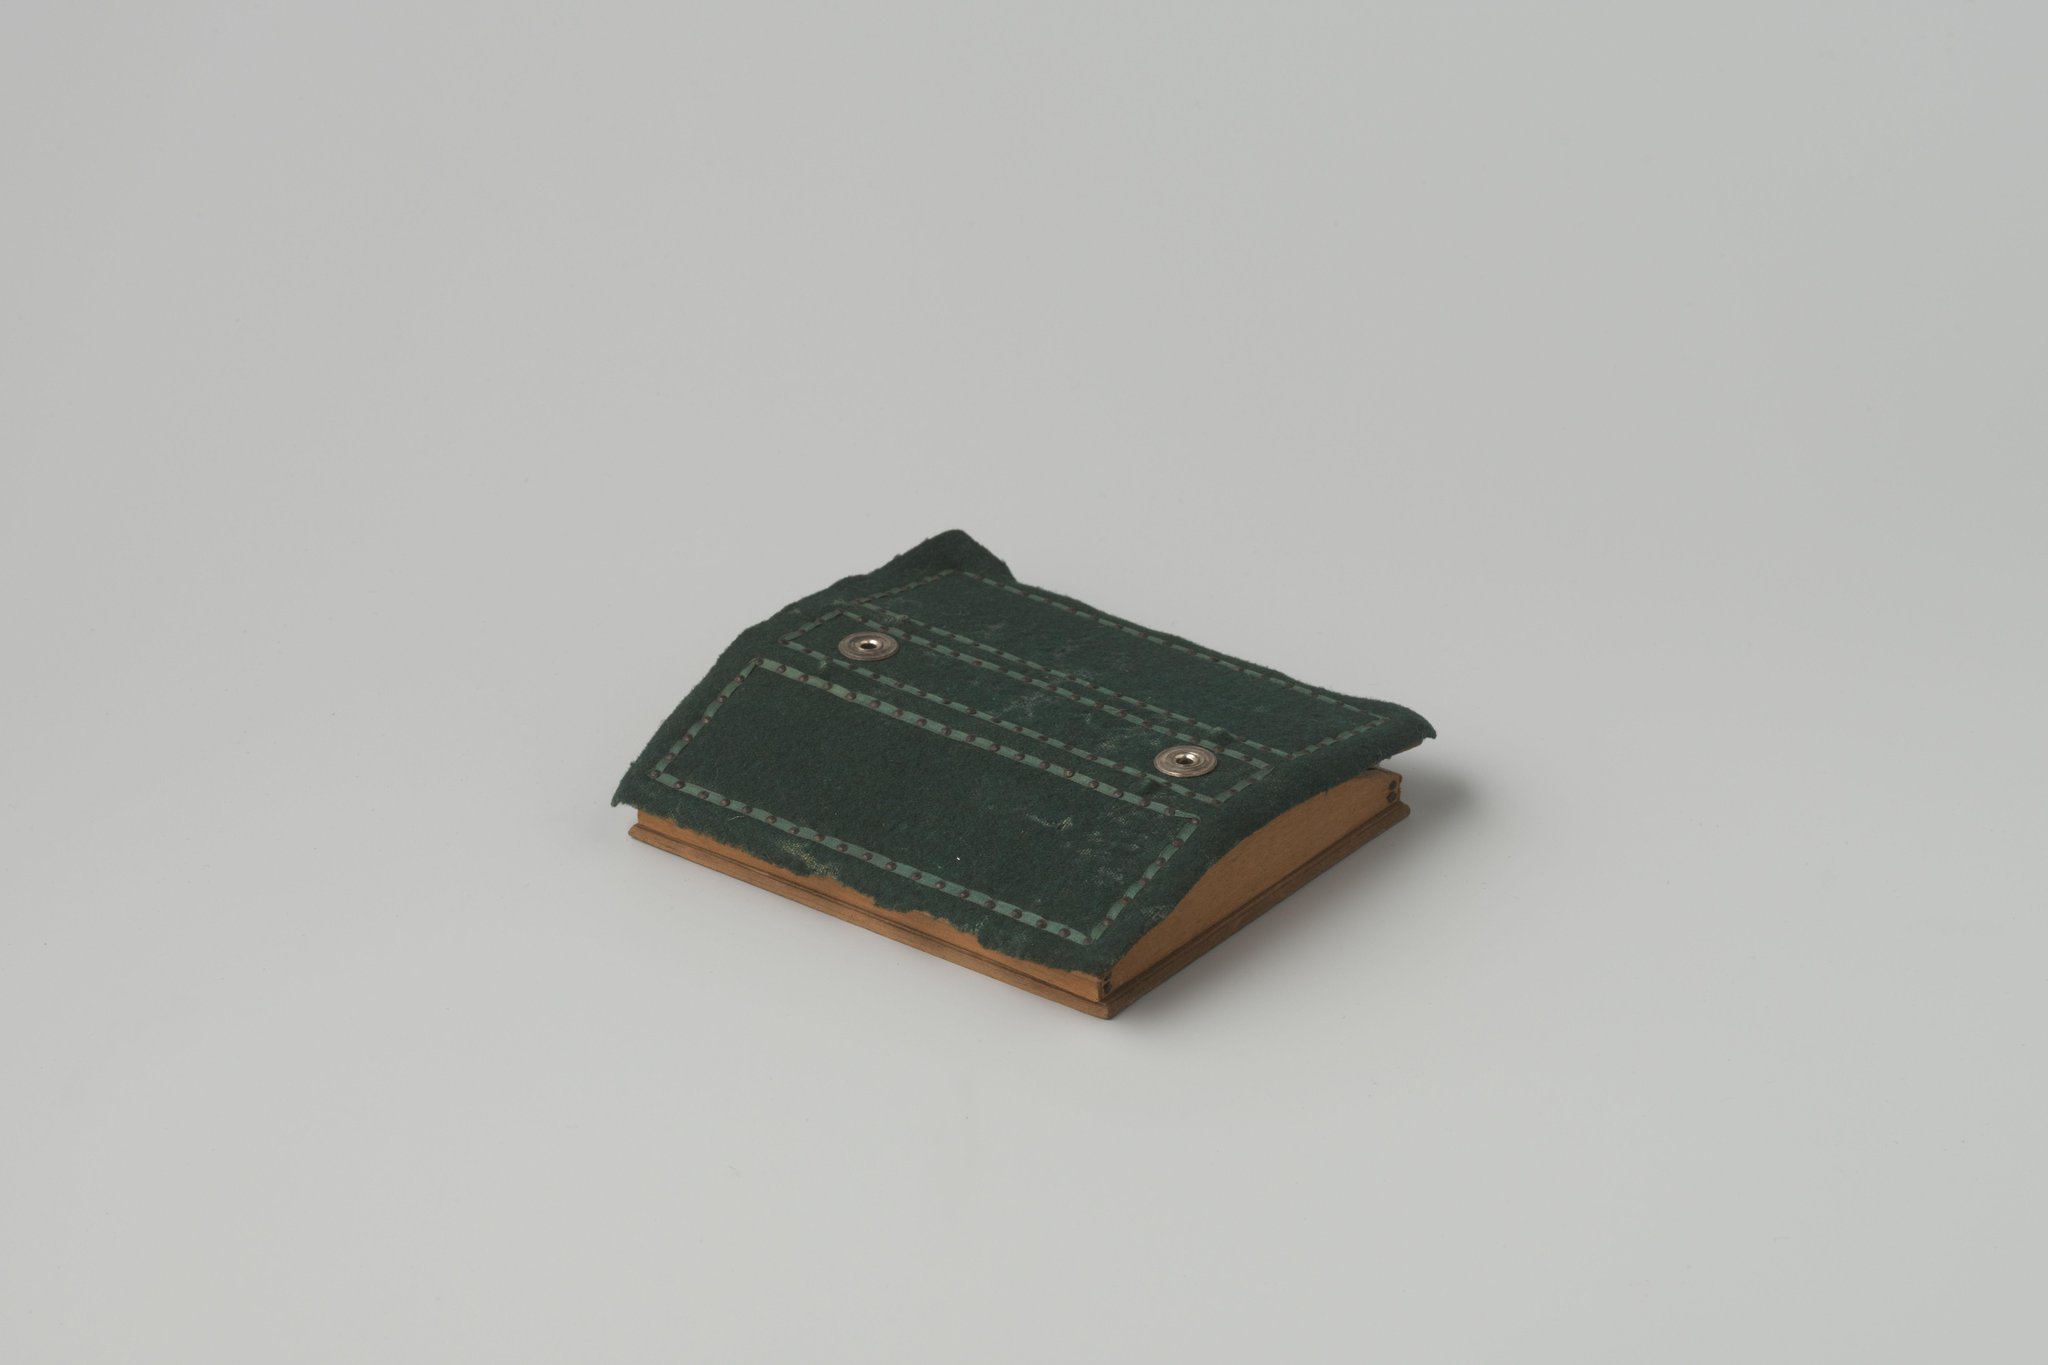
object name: miniature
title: Lessenaar vervaardigd van een without, los liggend op een tafel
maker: Anonymous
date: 1690-1710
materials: brass, wood, silver, wool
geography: amsterdam